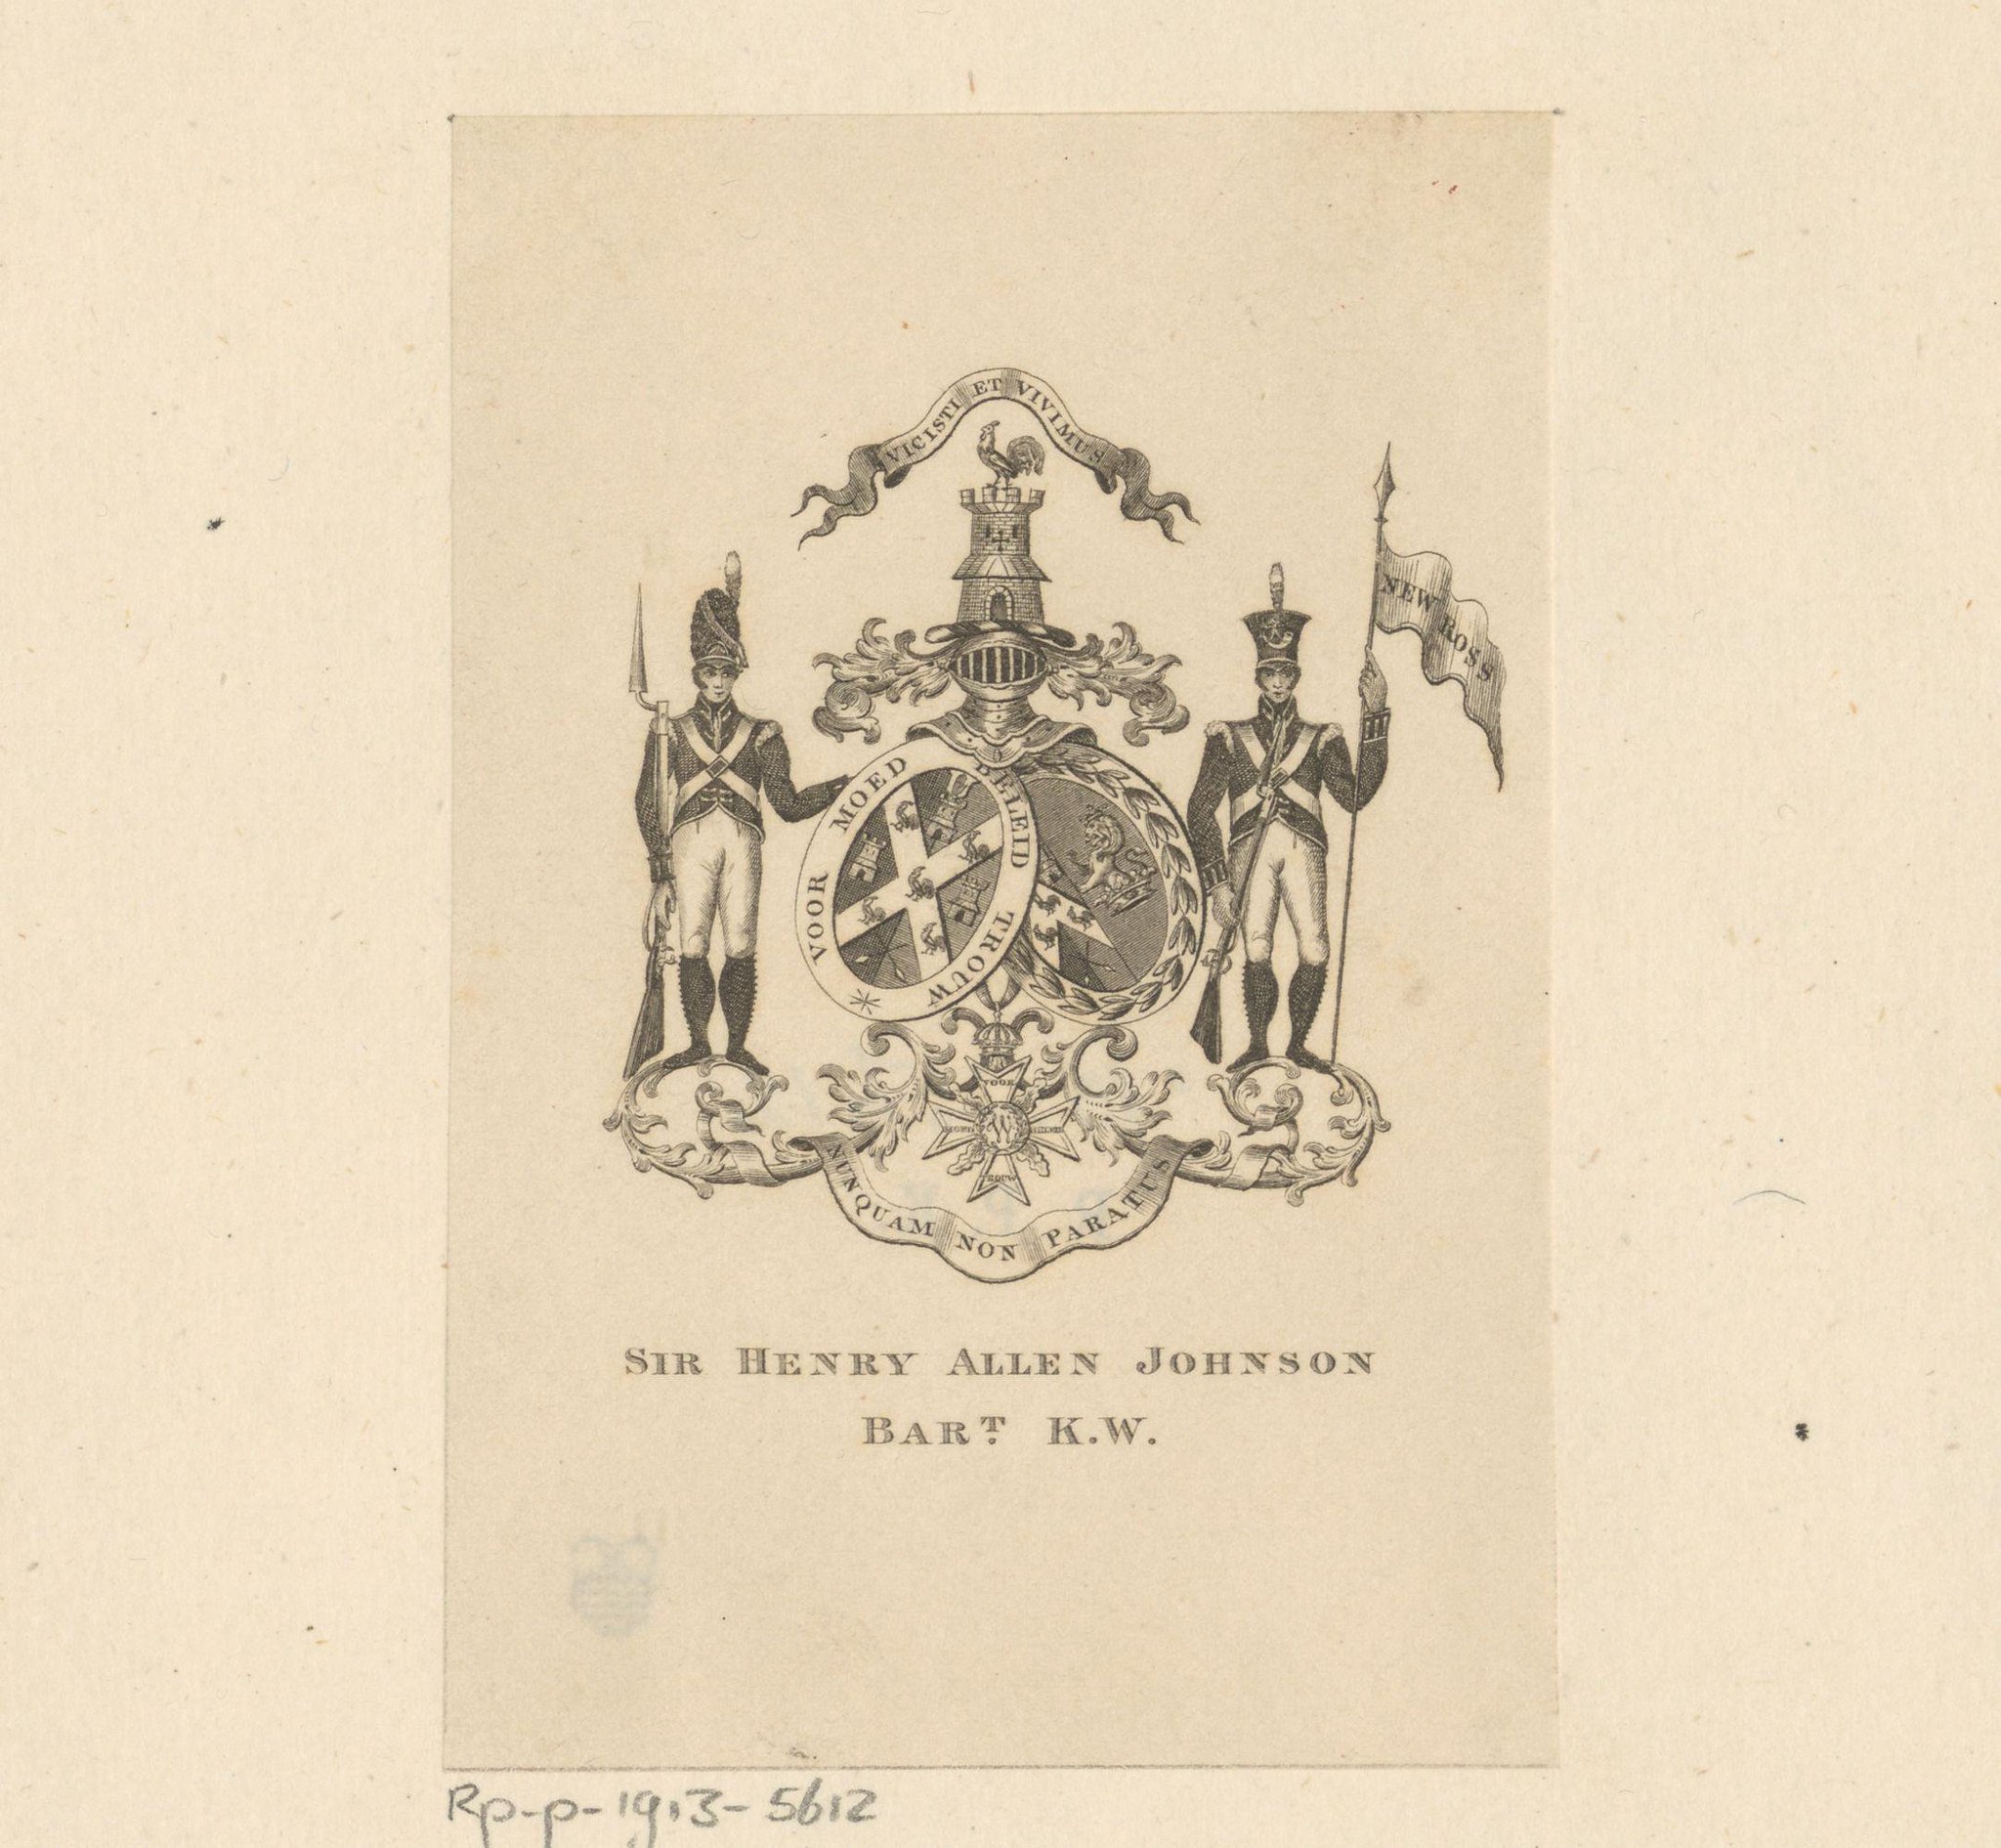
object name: bookplate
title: Vicisti et vivimus, nunquam non paratis / Voor moed beleid trouw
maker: Anonymous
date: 1795-1860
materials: paper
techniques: engraving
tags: armorial bearing, heraldry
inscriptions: collector's mark: Lugt 2233, collector's mark: Lugt 2760